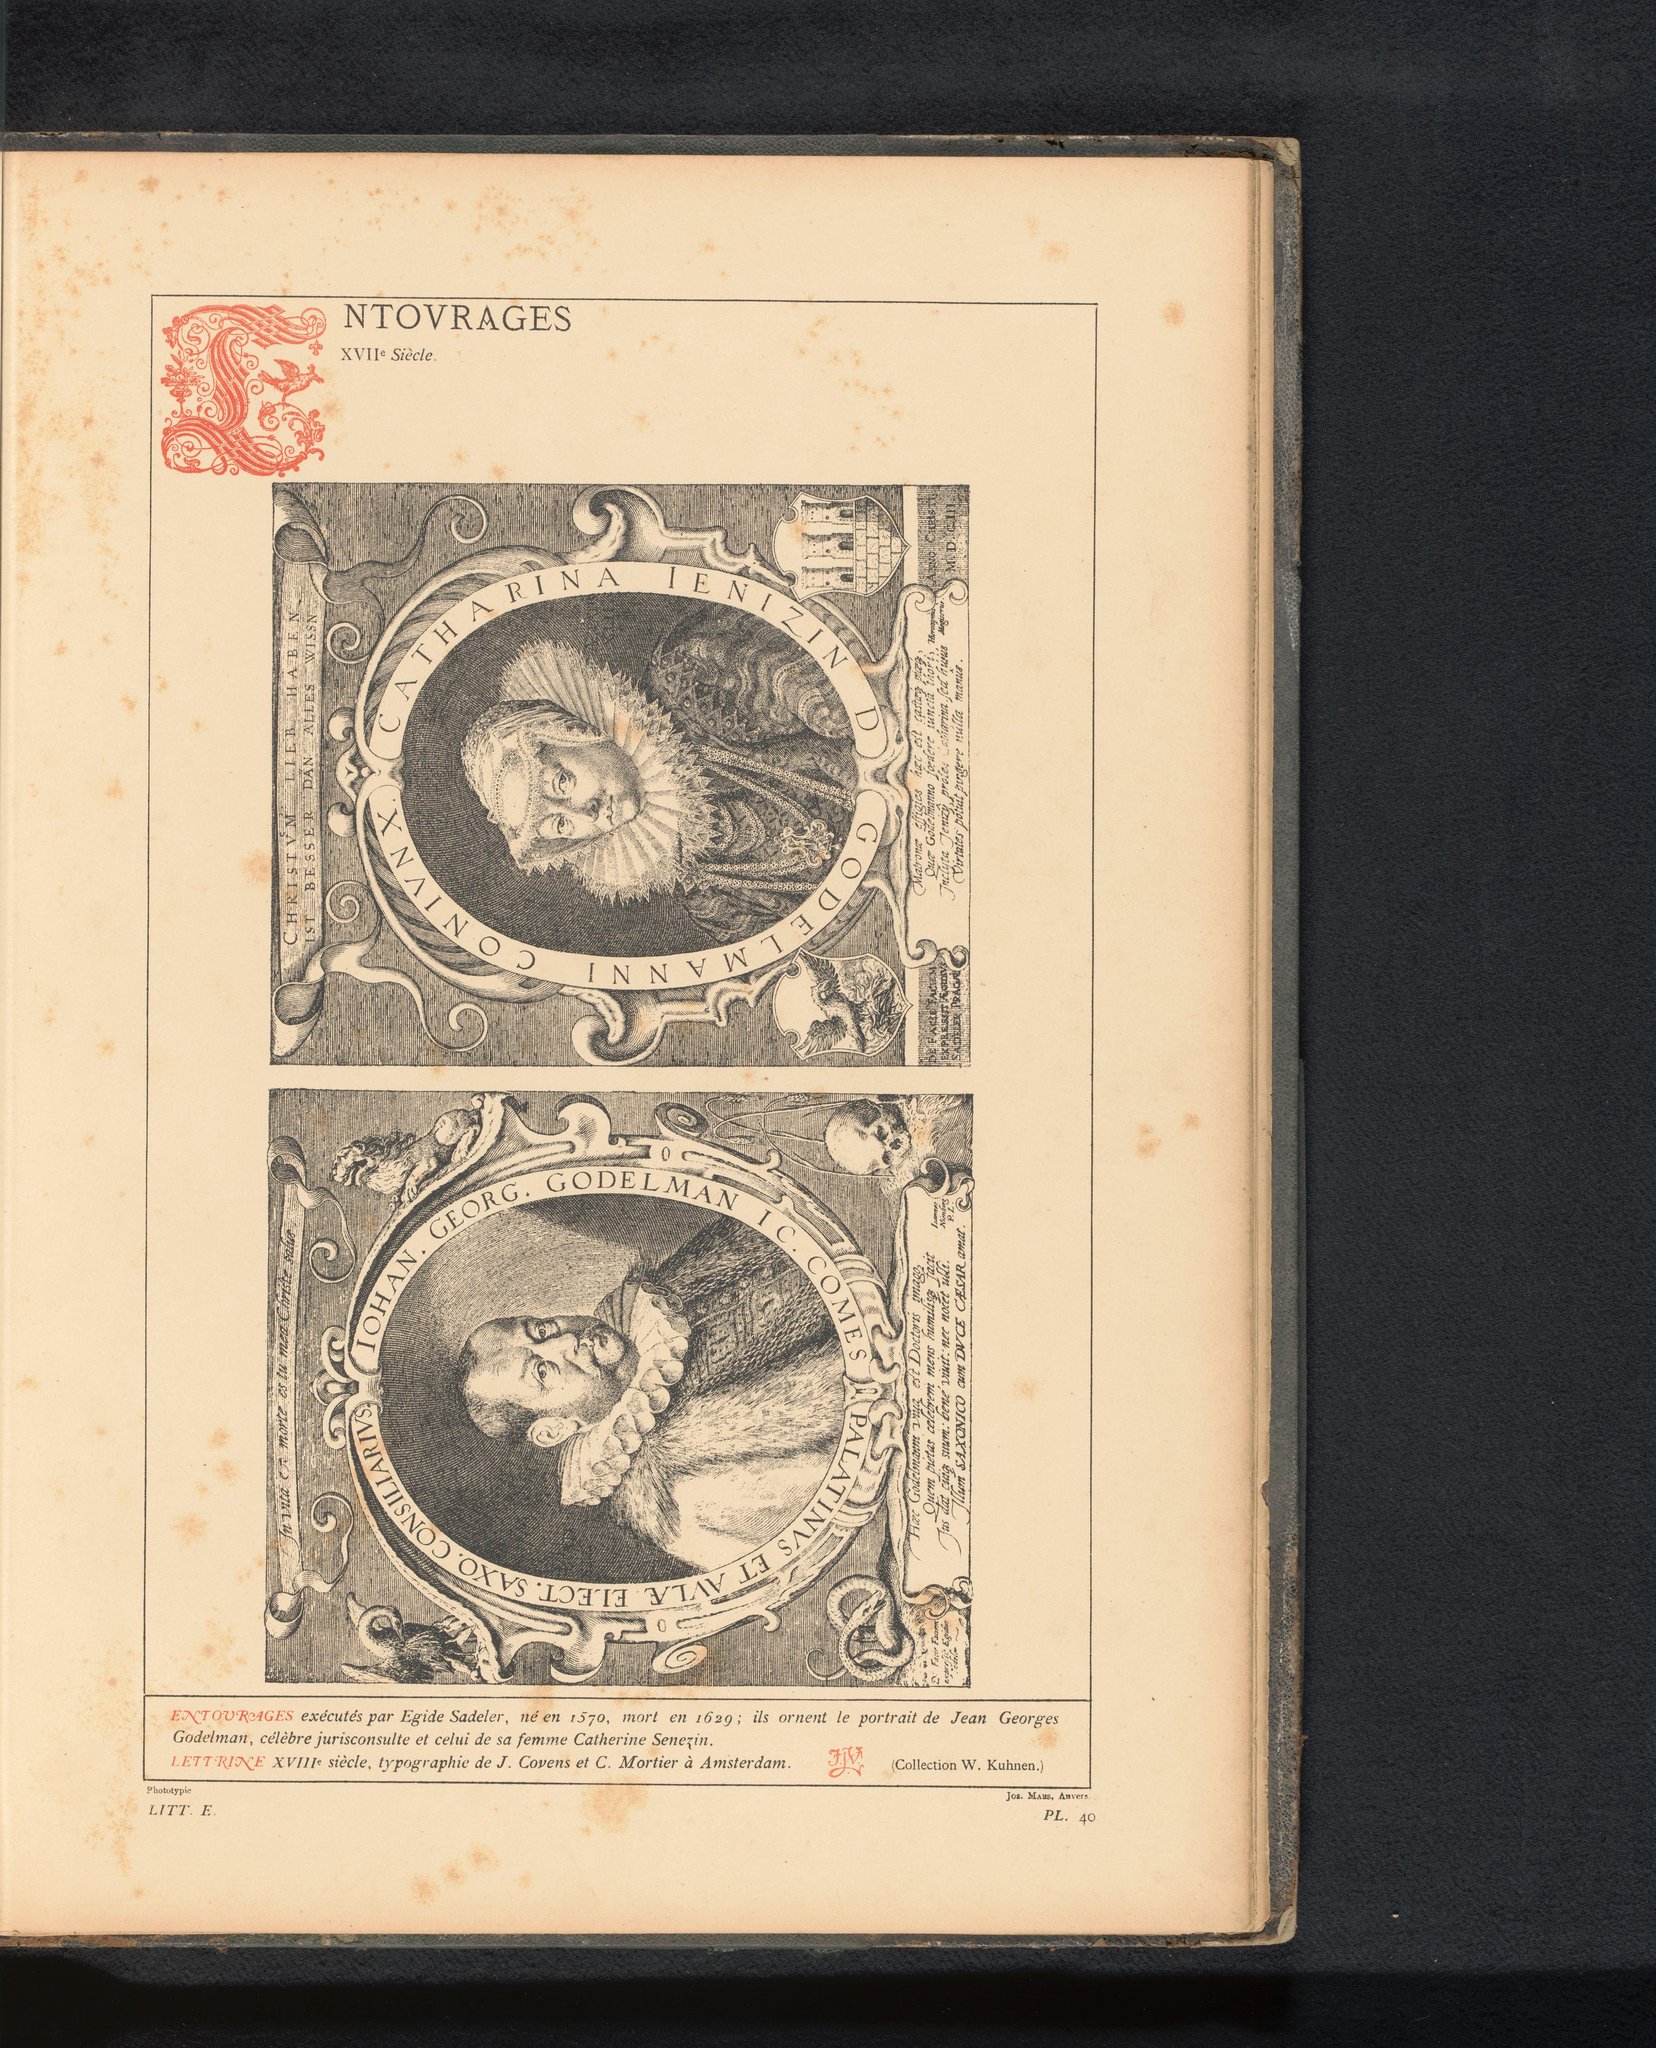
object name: reproduction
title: Reproductie van twee prenten met de portretten van Johann Georg en Catharina Jenizin Gödelmann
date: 1875-1880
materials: paper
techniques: photolithography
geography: amsterdam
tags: germany, historical persons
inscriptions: inscription: ‘ENTOURAGES exécutés par Egide Sadeler (...)’, monogram: ‘JJvY’, inscription: ‘LITT. E. - PL. 40’